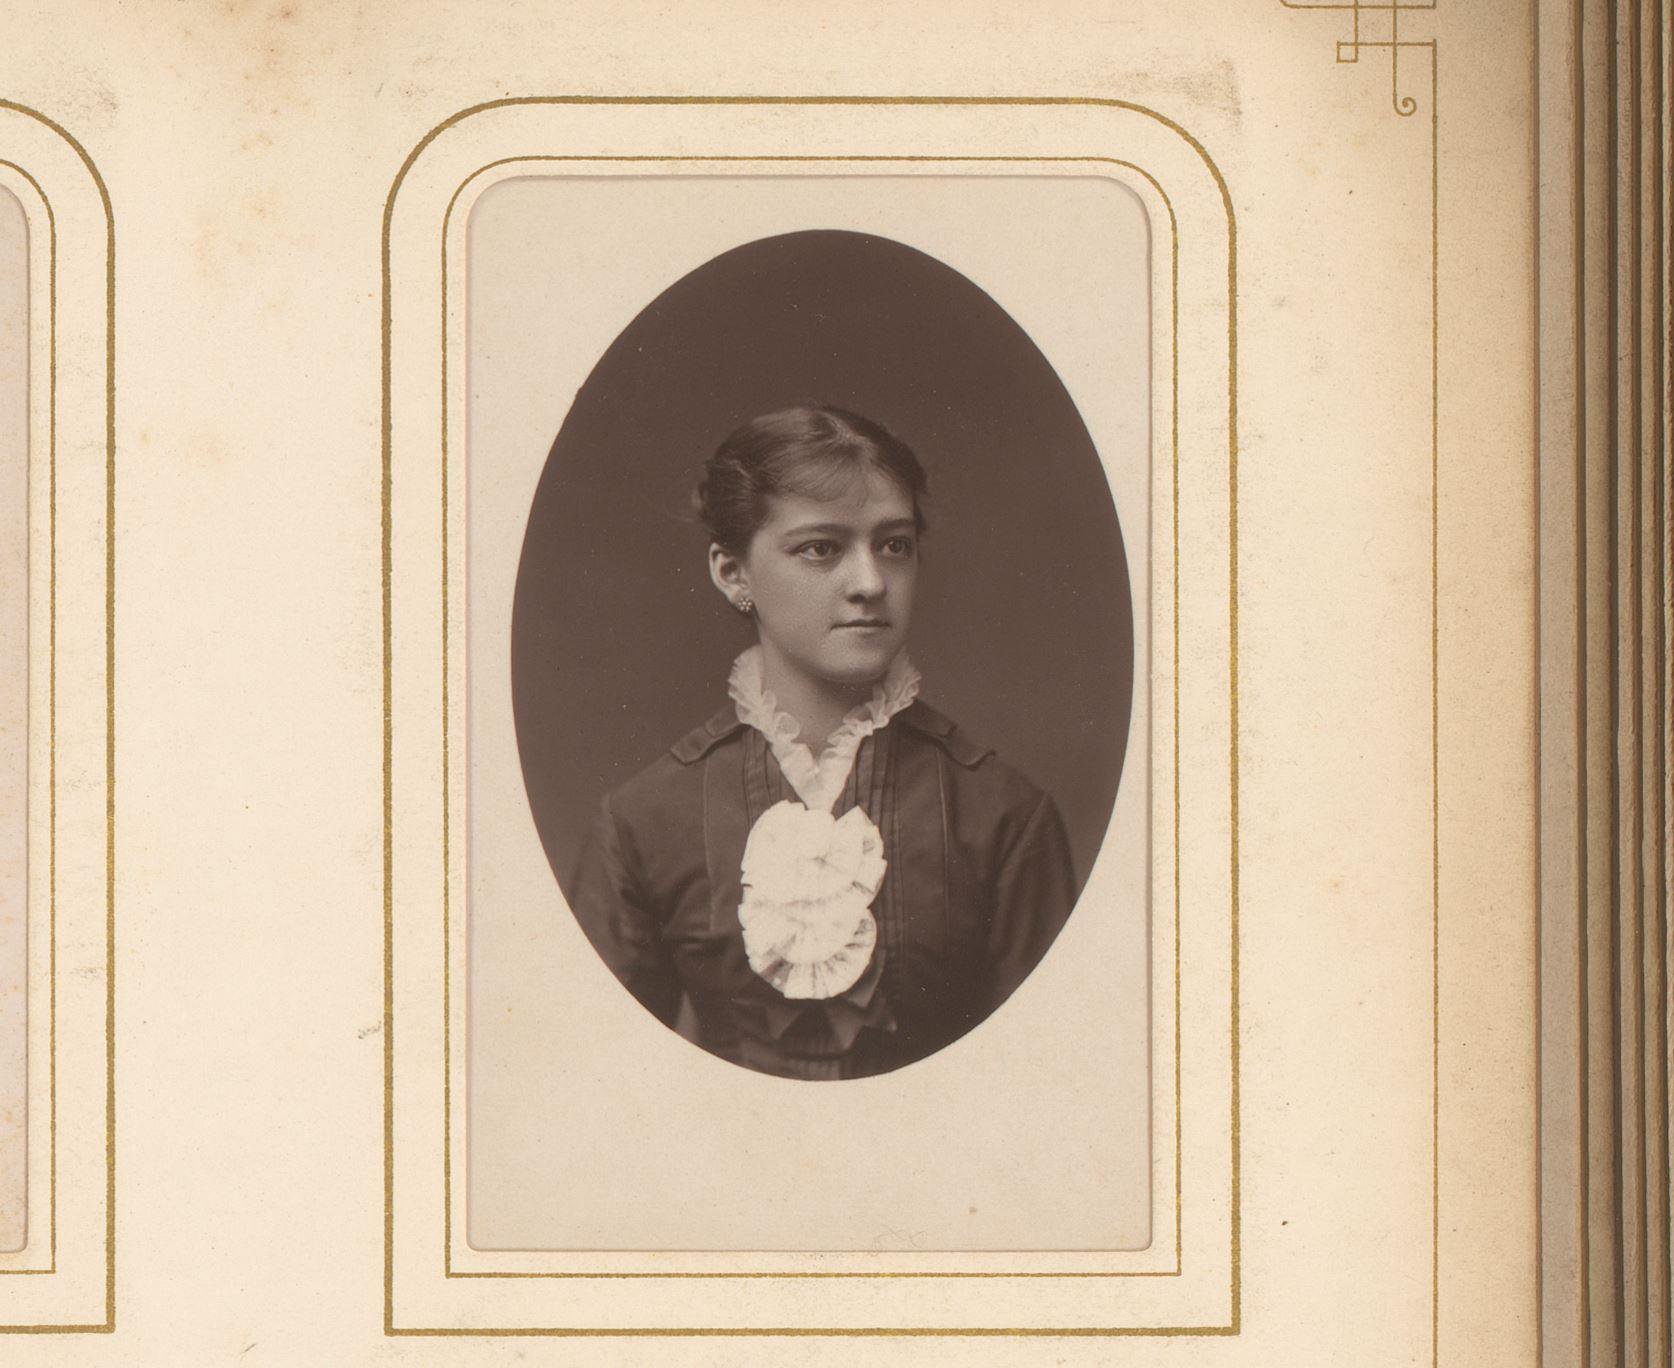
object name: album leaf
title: Portret van een jonge vrouw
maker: Anonymous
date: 1865-1890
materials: cardboard, paper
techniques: carbon print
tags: adolescent, young woman, maiden, historical persons - bb - woman